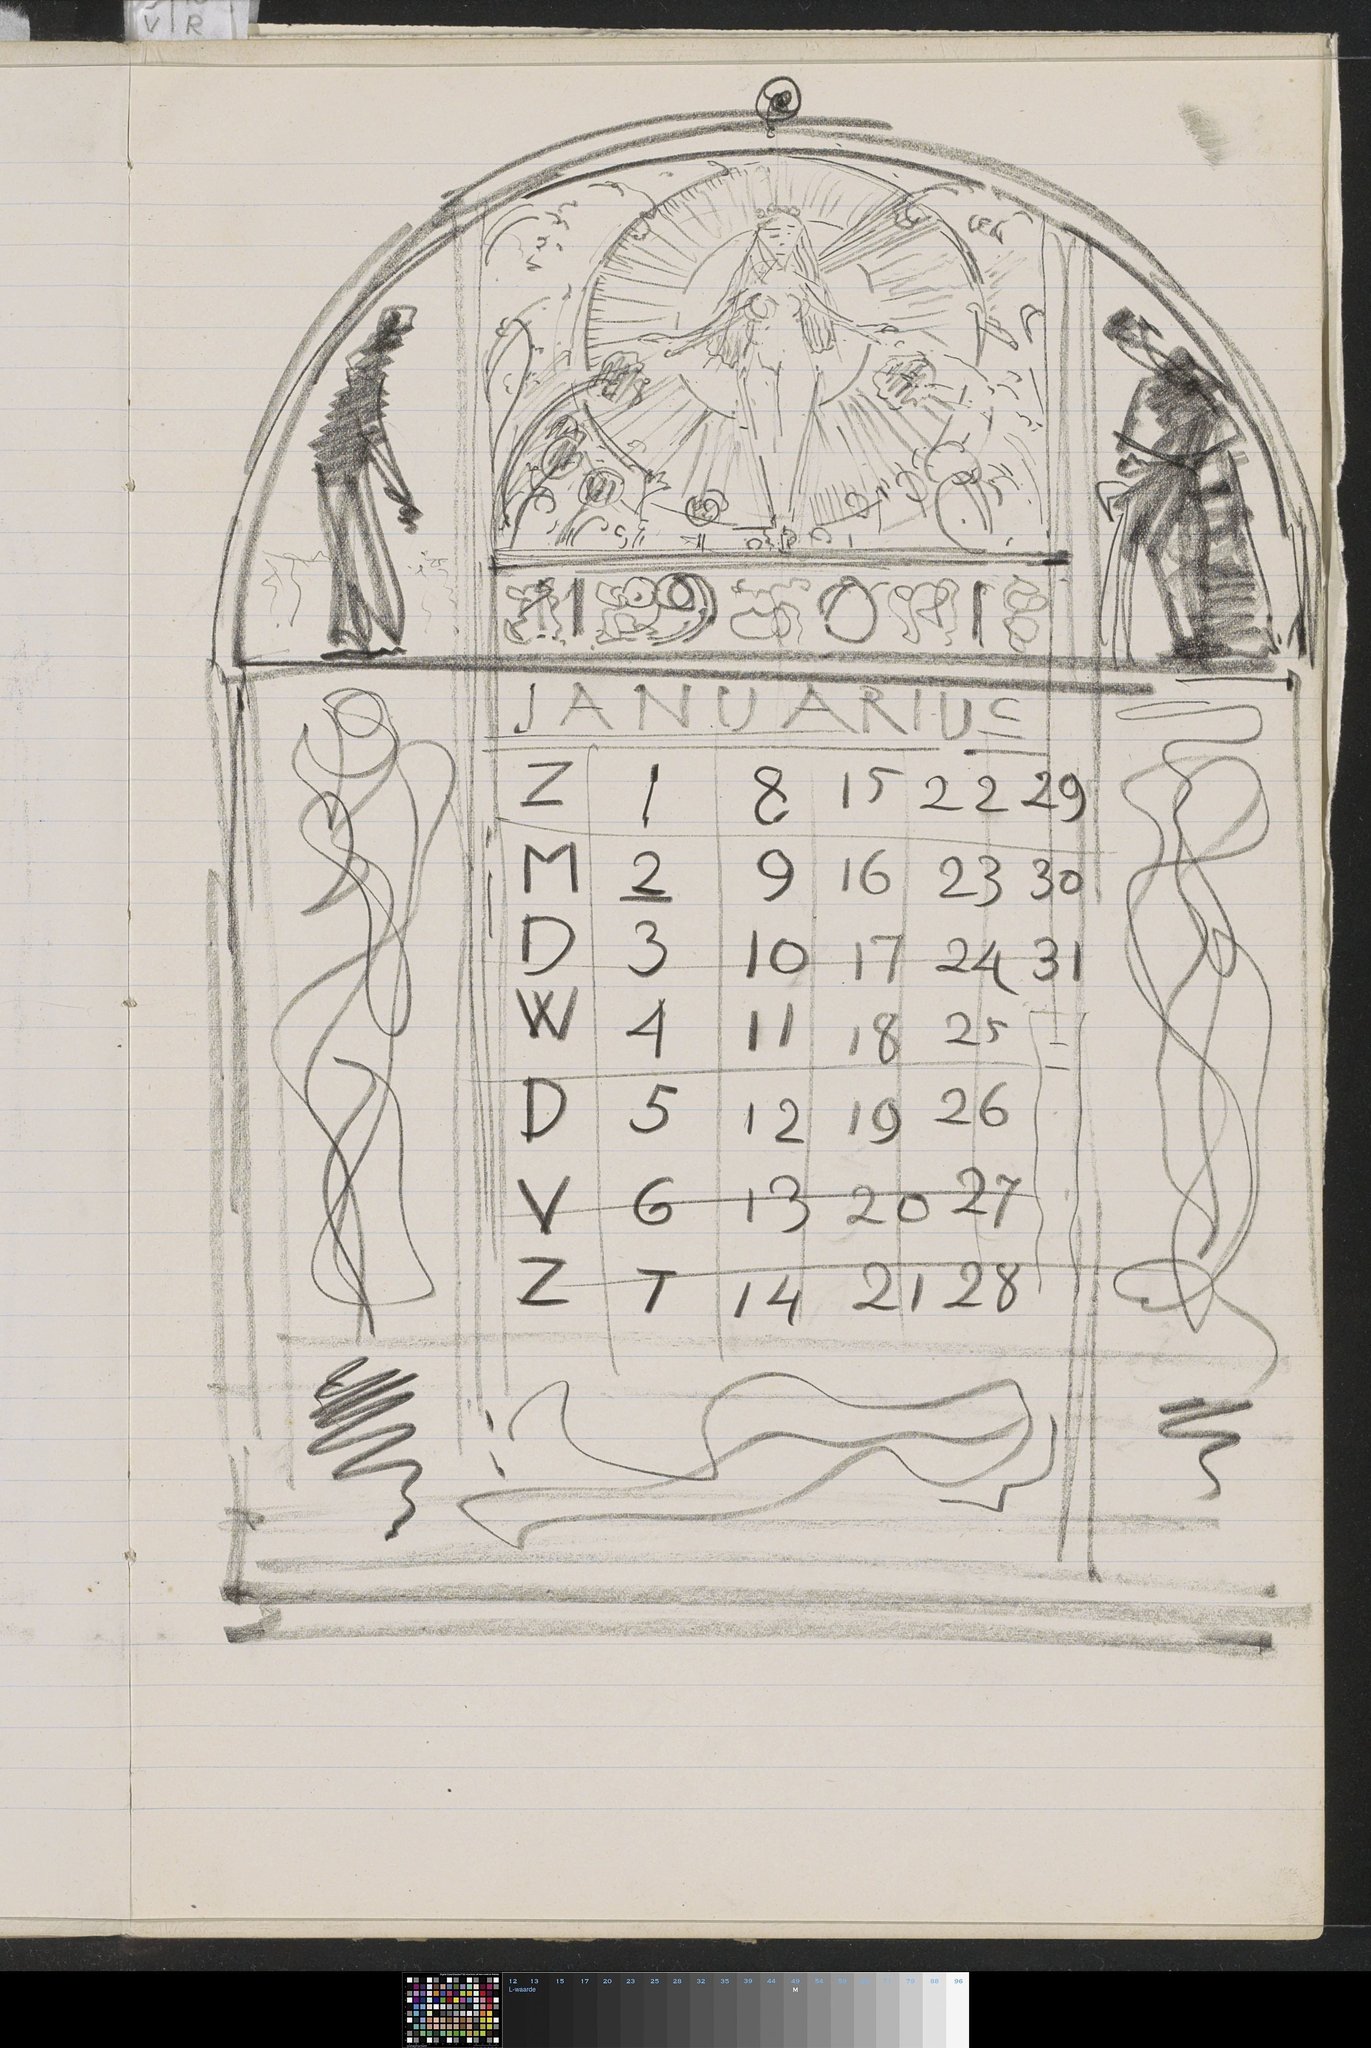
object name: sketchbook leaf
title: Ontwerp voor een kalender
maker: gerrit willem dijsselhof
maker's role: designer, draughtsman, print maker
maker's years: 1866-1924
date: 1901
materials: chalk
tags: calendar, almanac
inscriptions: annotation: ‘1901/ JANUARIE/ [...]’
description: Blad 6 recto uit een schetsboek met 79 bladen.